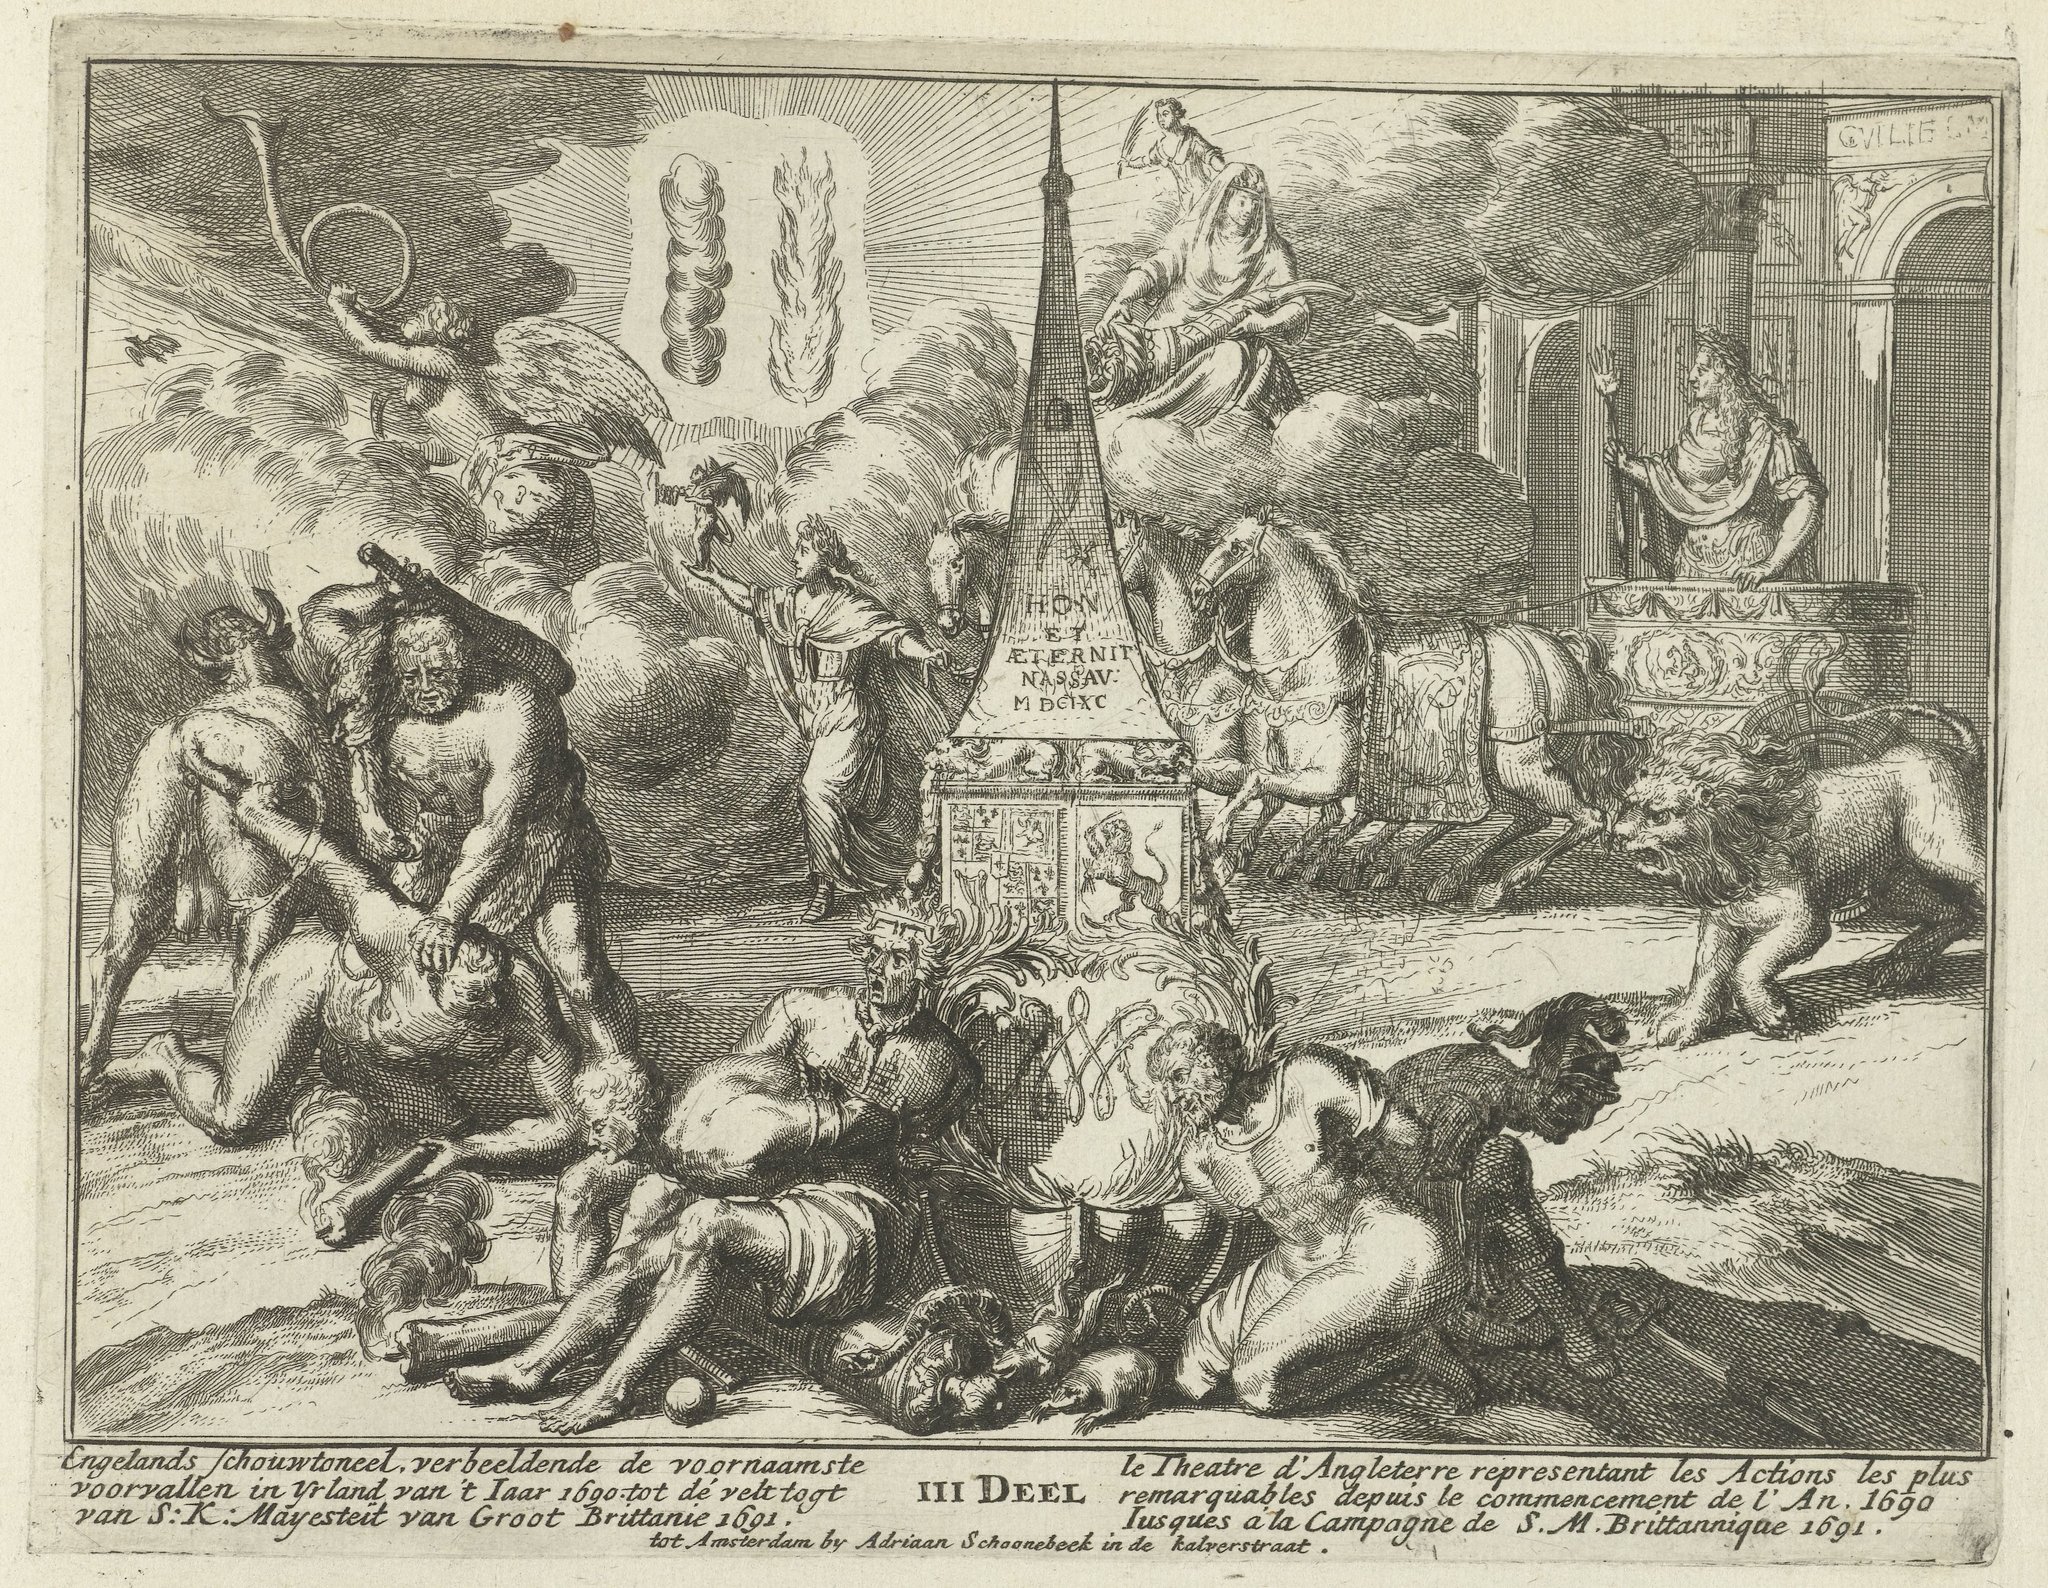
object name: titelprent, frontispice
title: Titelprent voor het derde deel van 'Engelants schouwtoneel'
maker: adriaen schoonebeek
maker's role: print maker, publisher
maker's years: 1661-1705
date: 1691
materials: paper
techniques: etching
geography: amsterdam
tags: william iii (prince of orange and king of england, scotland, and ireland), title-page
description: Allegorische titelpagina met triomf van koning Willem III in strijdwagen voorafgegaan door Vrede en Faam. Op de voorgrond de verslagen en geboeide vijanden van het land. Titelprent voor de serie 'Engelants schouwtoneel' over de oorlog tussen Willem III en Jacobus II in de jaren 1690-1691 na de Glorious Revolution, (derde deel). Met onderschriften in het Nederlands en Frans.